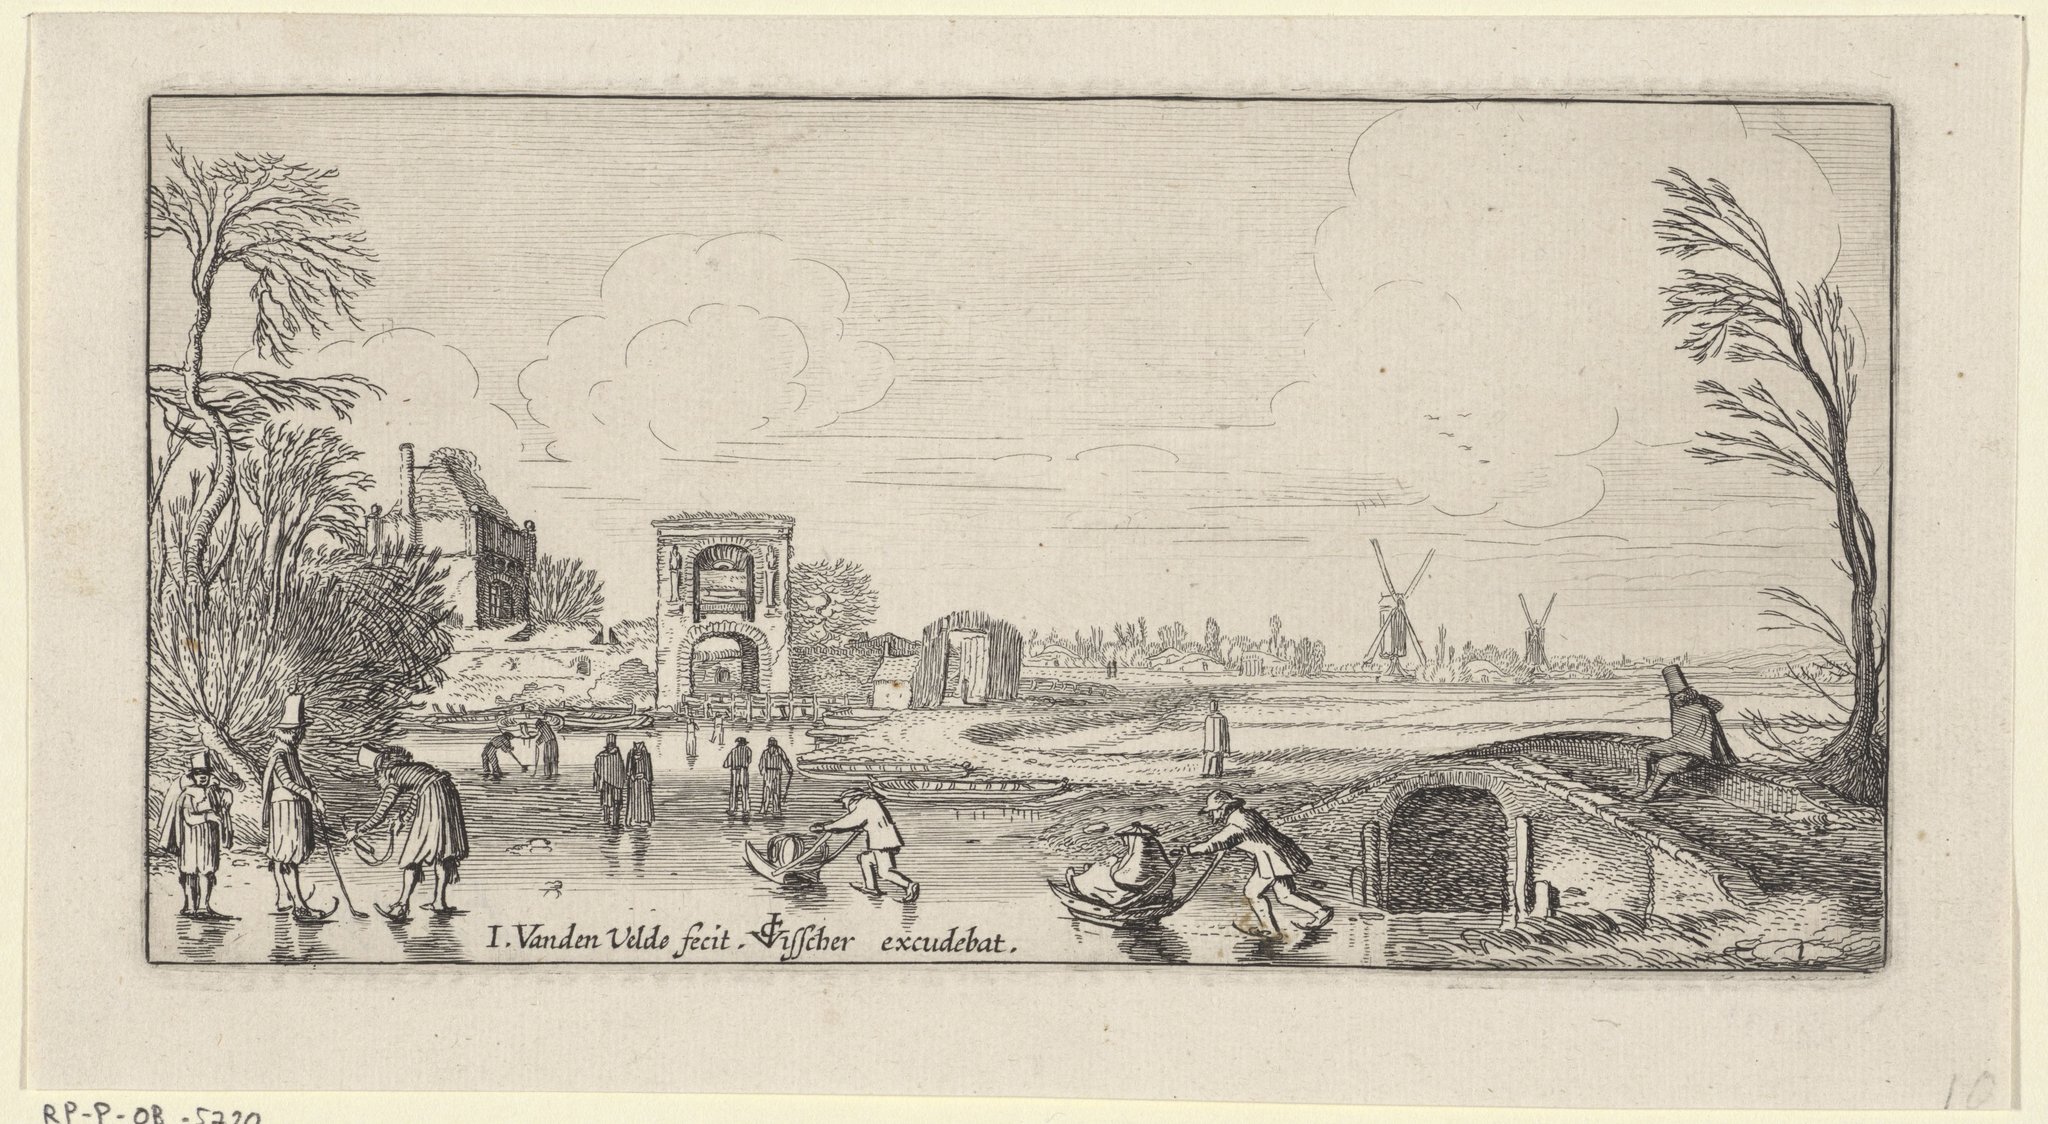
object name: print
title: Landschappen, klein formaat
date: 1603-1641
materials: paper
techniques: etching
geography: northern netherlands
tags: landscape with bridge, viaduct or aqueduct, gate, entrance, windmill in landscape, skates (winter sports), 'kolf' on the ice, small sleigh (winter sports)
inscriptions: collector's mark: Lugt 240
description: Kolfspelers en schaatsers op het ijs nabij de Haarlemse Zijlpoort. Aan de horizon zijn twee molens te zien. Eerste prent uit een serie van zes.